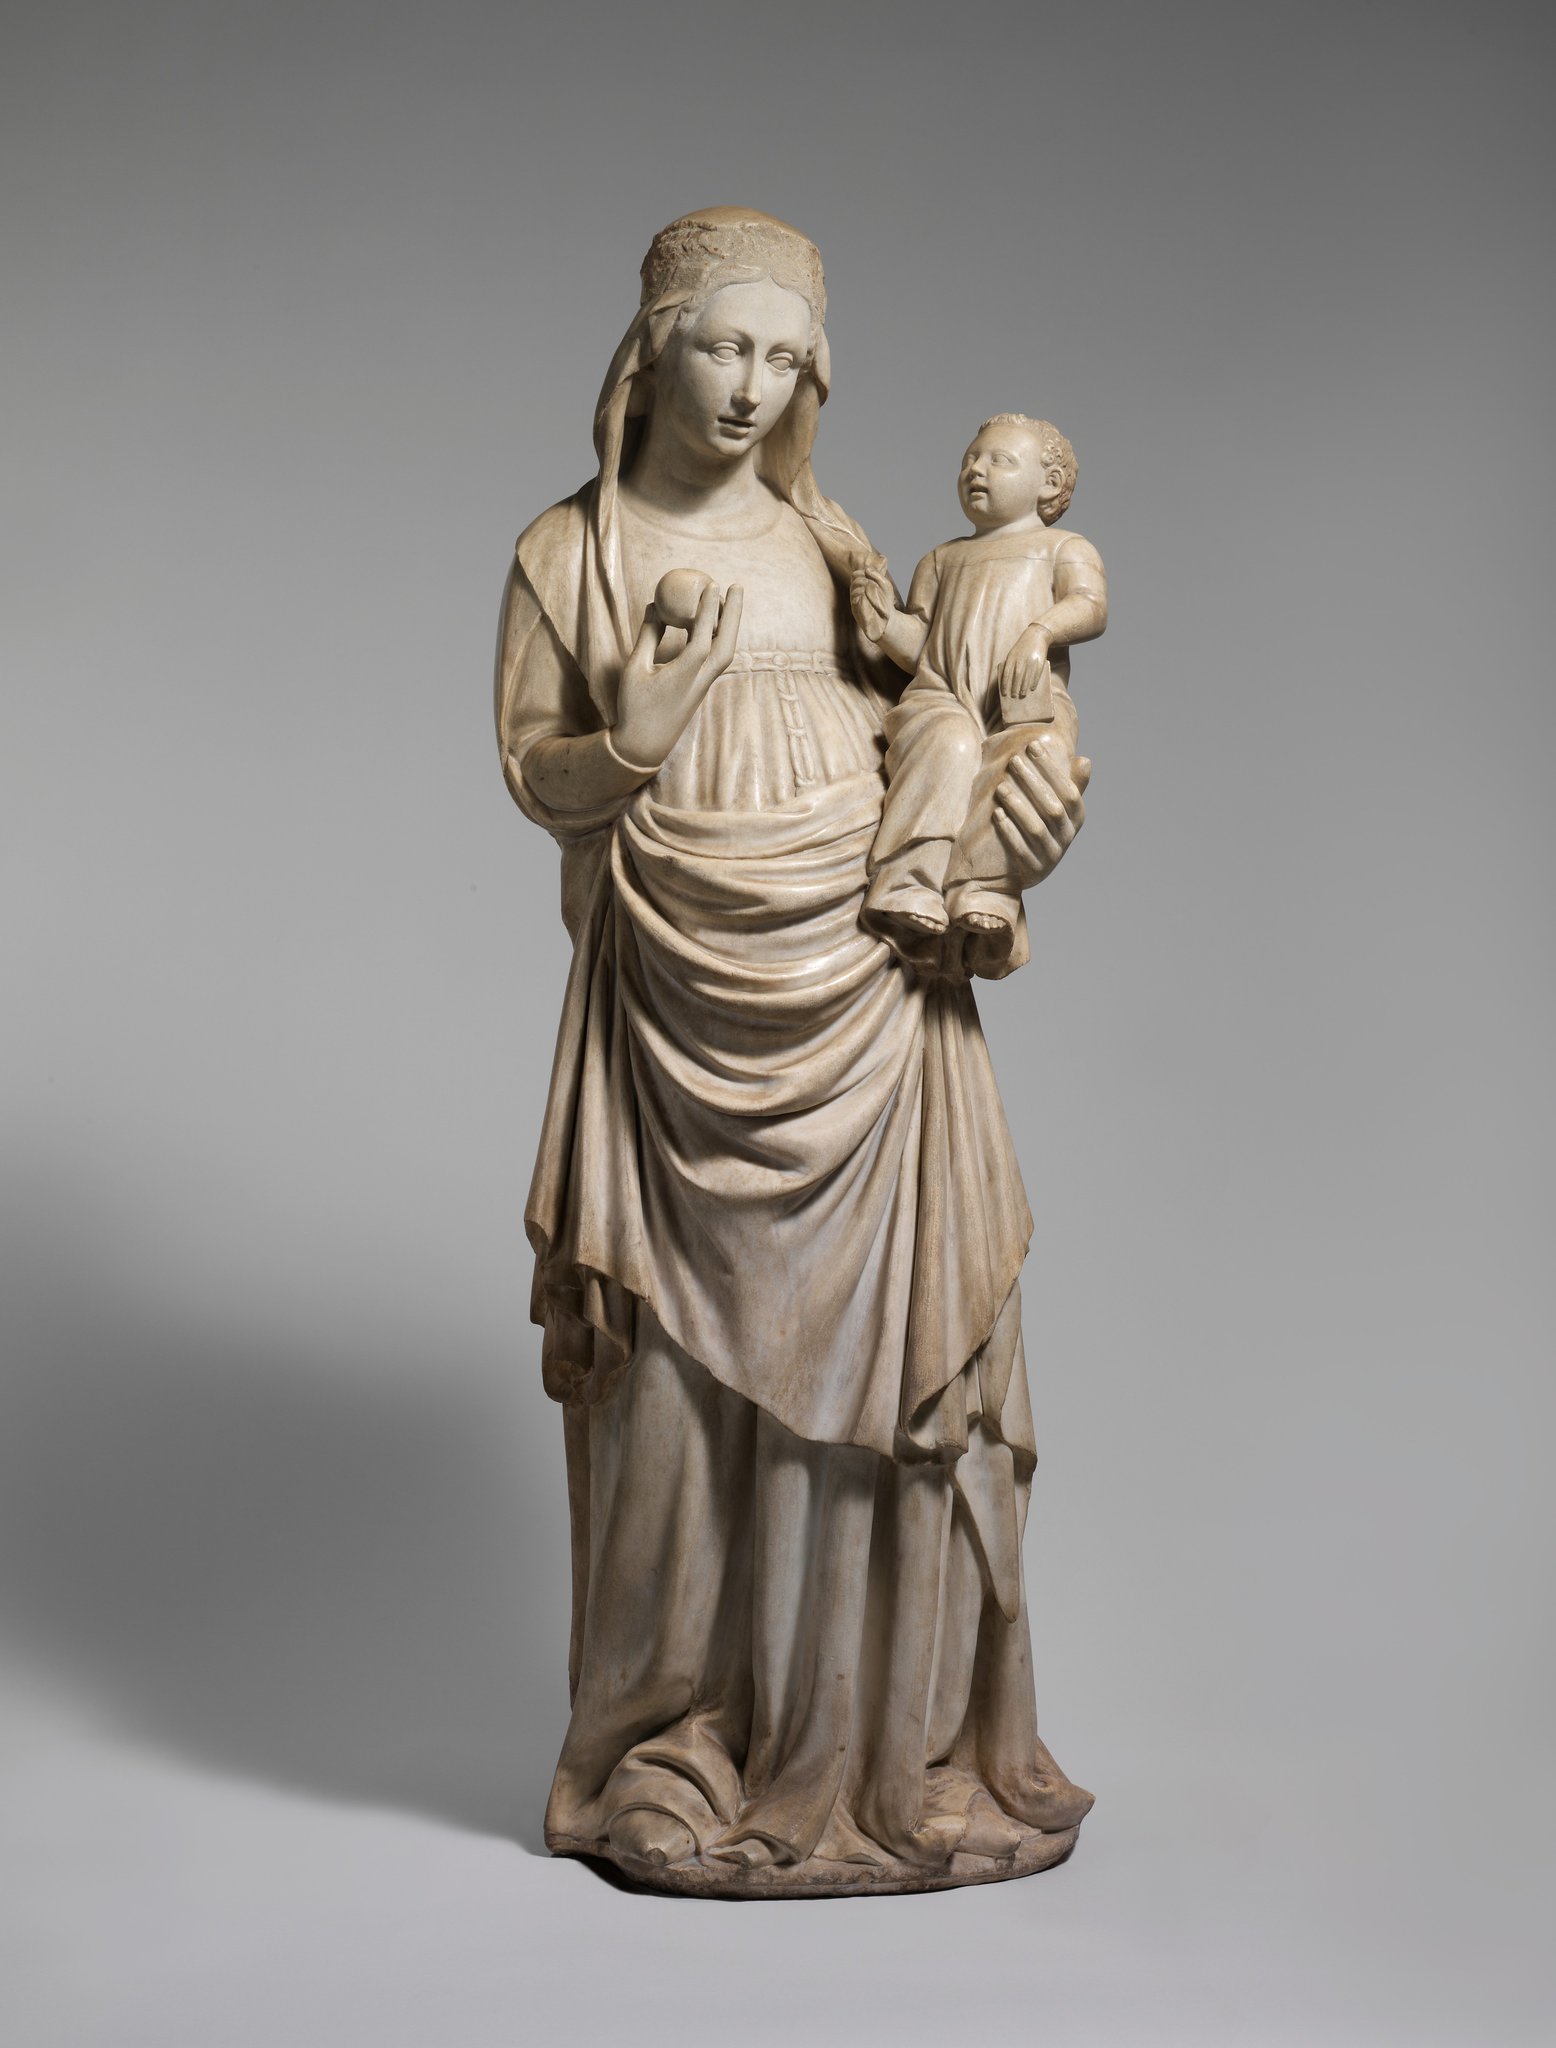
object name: statue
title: Standing Virgin and Child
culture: north italian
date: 1425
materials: marble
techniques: gilding, polychromy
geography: italy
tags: madonna and child